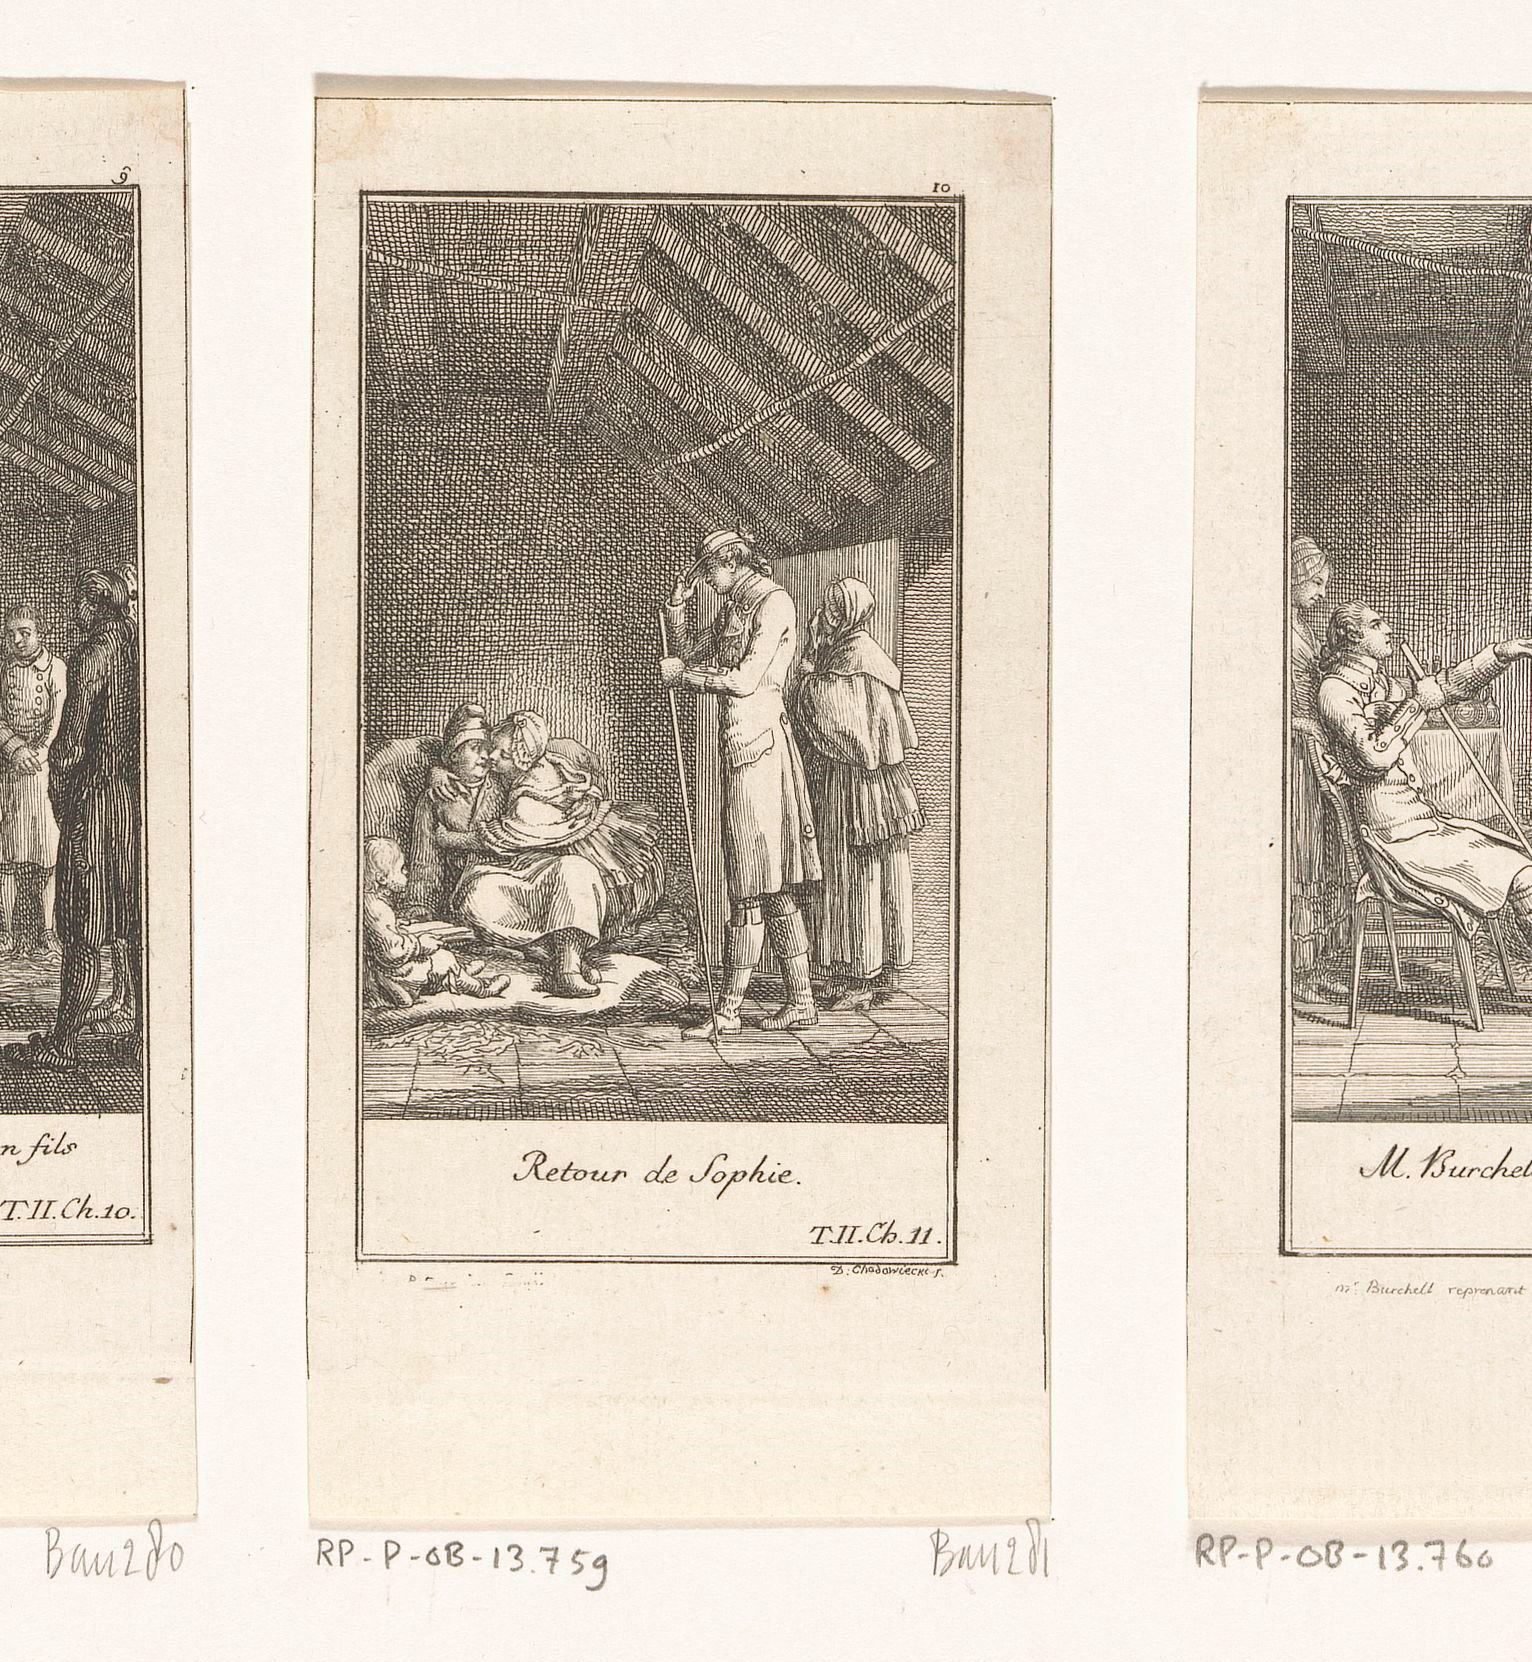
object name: print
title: Terugkomst van Sophie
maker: daniel nikolaus chodowiecki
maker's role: draughtsman, print maker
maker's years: 1726-1801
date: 1776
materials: paper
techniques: etching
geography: berlin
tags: oliver goldsmith, prison, jail, father and daughter(s) (family group), (goldsmith, the vicar of wakefield) specific works of literature (with author, title)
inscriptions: collector's mark: Lugt 2228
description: Tiende scène uit een serie van twaalf scènes die 'The Vicar of Wakefield' door Oliver Goldsmith illustreren. De scènes werden op een plaat geëtst. Deze serie is gebruikt in: 'Almanac Généalogique pour l'an 1777 etc. À Berlin'.